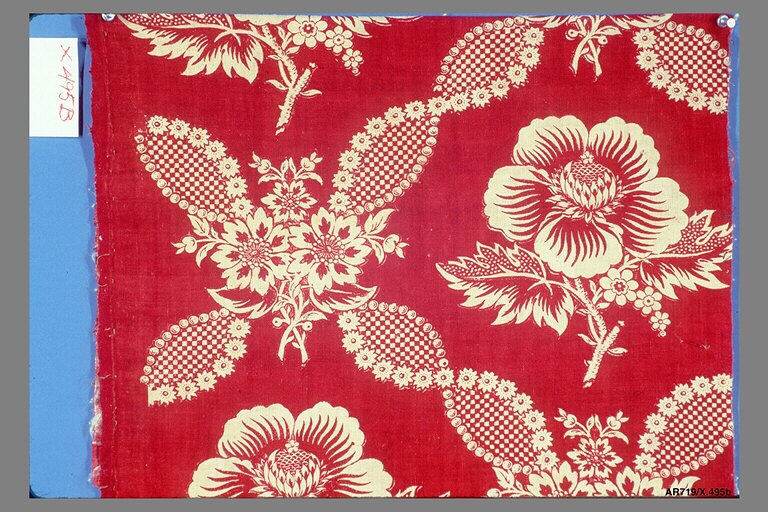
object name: piece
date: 1701-1800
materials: cotton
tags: flowers